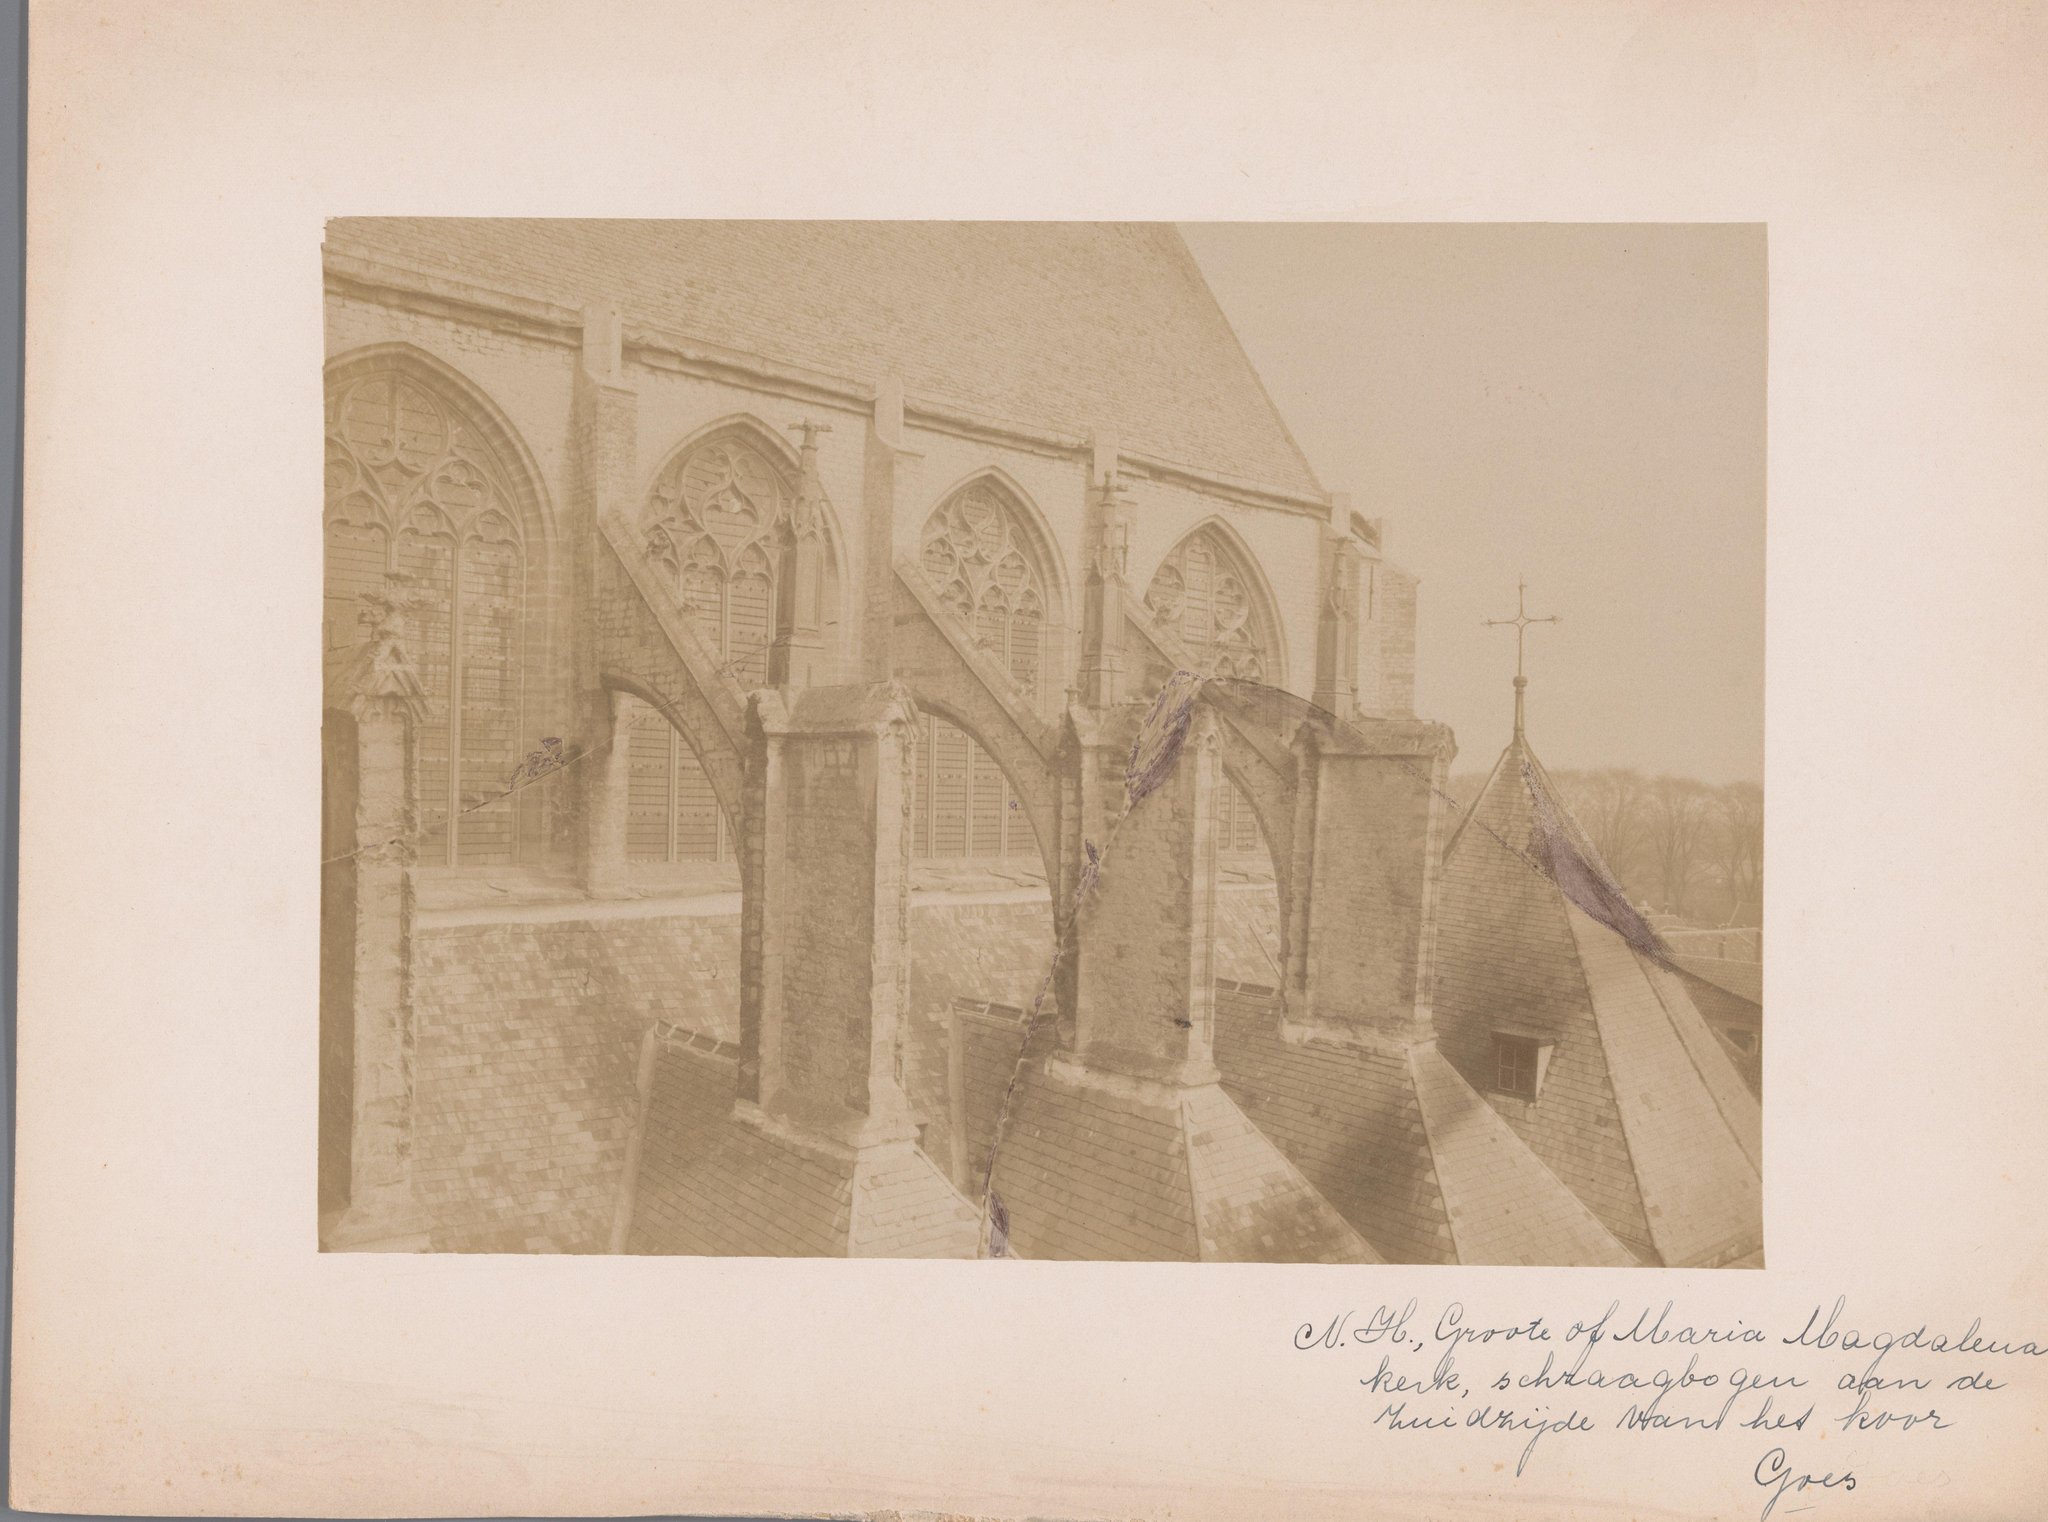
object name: photograph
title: Luchtbogen van de Grote of Maria Magdalenakerk te Goes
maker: anoniem (monumentenzorg)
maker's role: fotograaf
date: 1890-1920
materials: cardboard, photographic support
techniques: albumen print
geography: goes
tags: parts of church exterior and annexes: choir, arch, archivolt ~ architecture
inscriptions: annotation: ‘N.H., Groote of Maria Magdalenakerk, schraagbogen aan de Zuidzijde van het koor/ Goes’, annotation: ‘N.H. kerk te goes (Z.)/ Schraaf bogen aan den Zuidzijde van het koor’